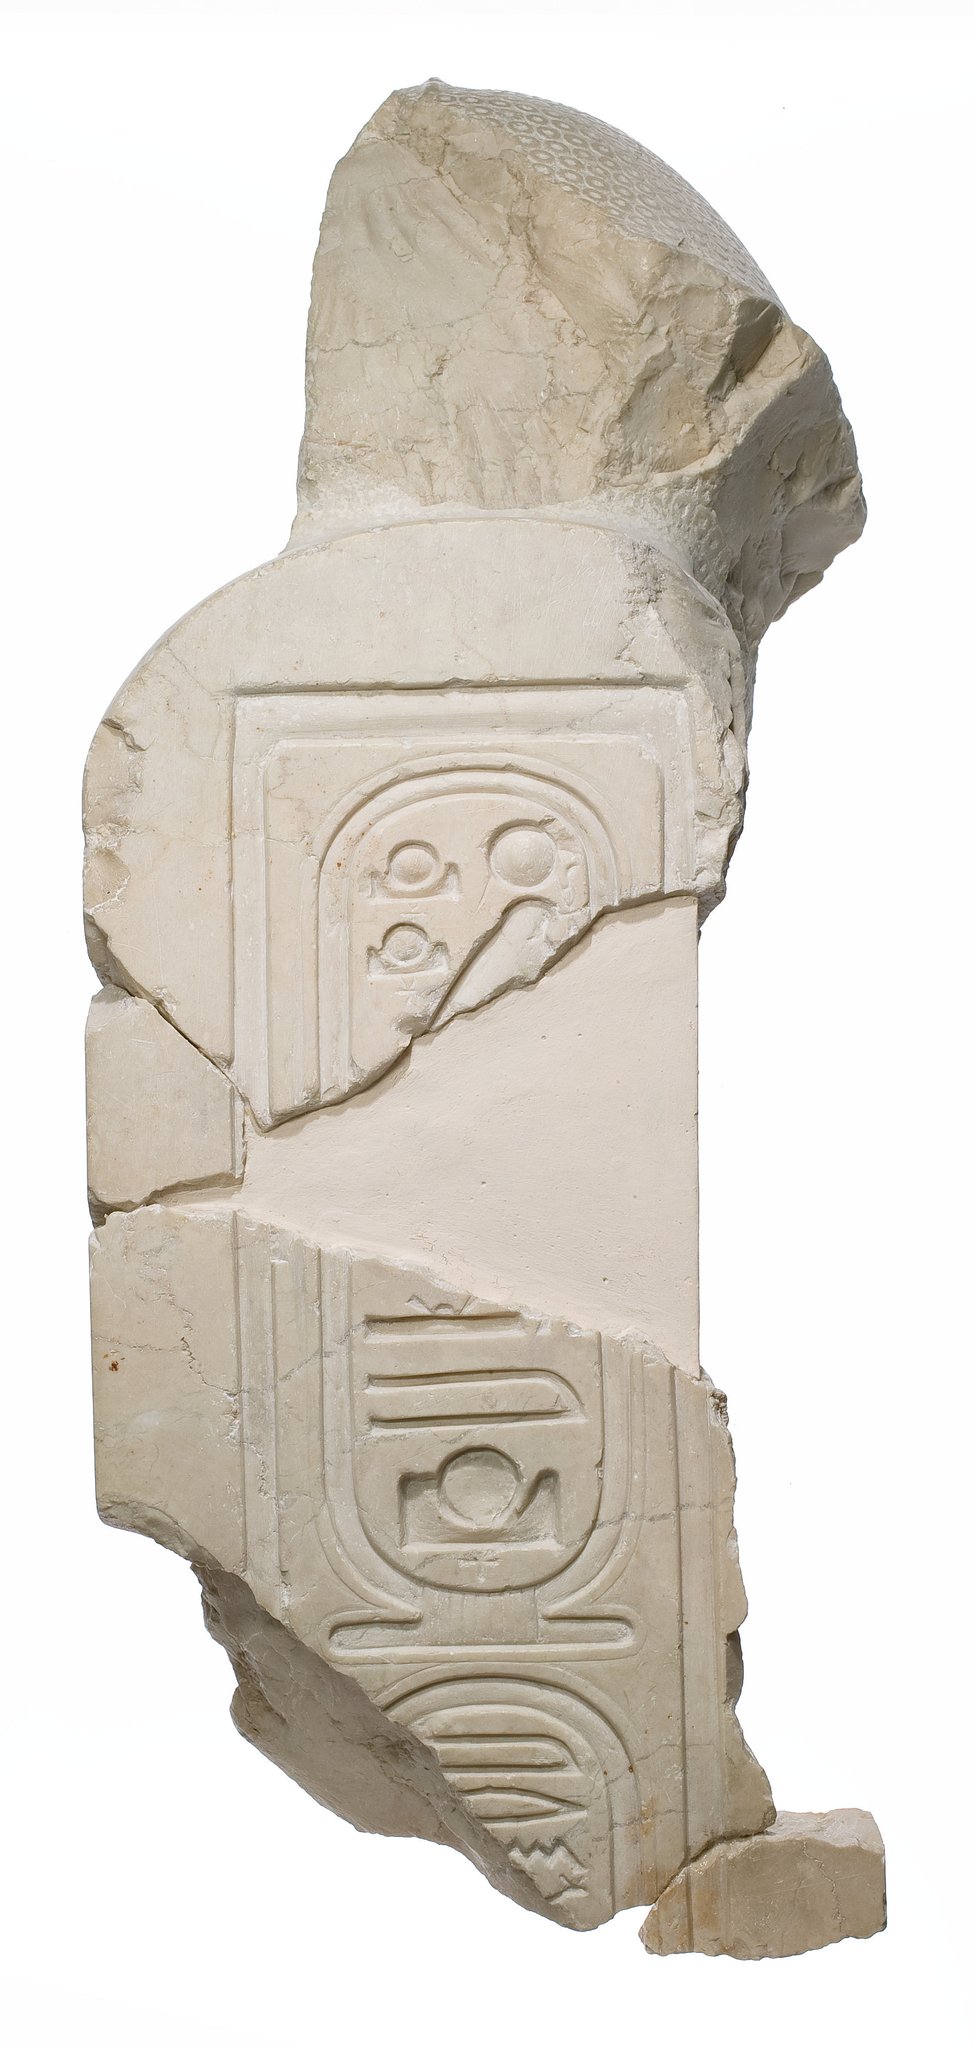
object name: head of akhenaten, back pillar, aten name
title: Head of Akhenaten with back pillar inscribed with Aten names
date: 1353-1336 BCE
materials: limestone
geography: egypt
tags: hieroglyphs